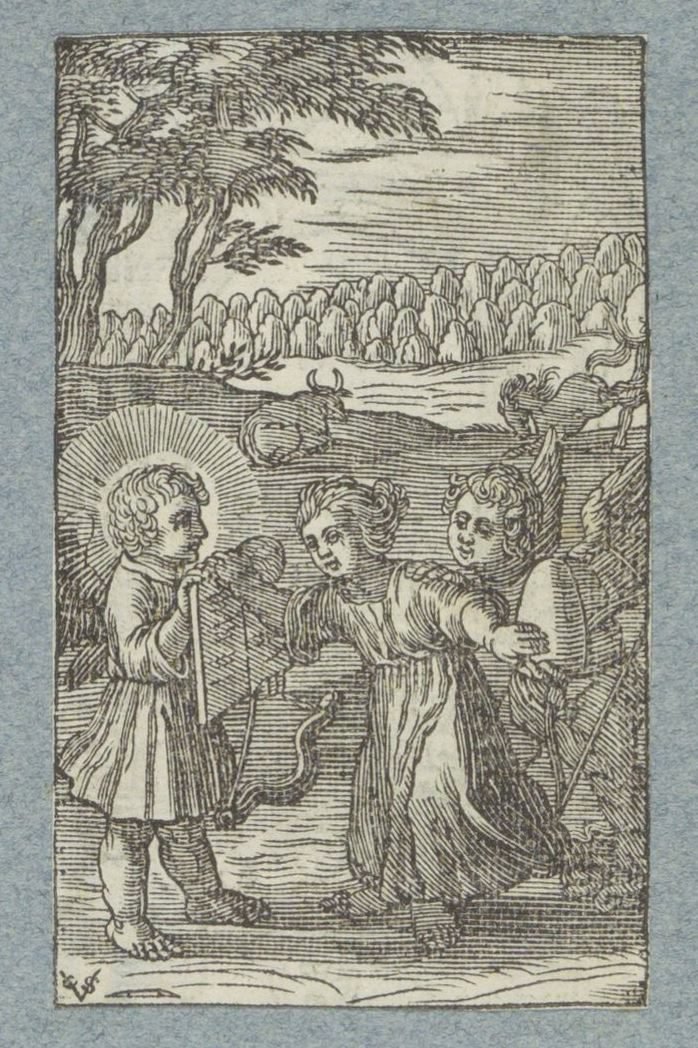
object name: album leaf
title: Pia Desideria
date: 1628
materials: paper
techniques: woodcut, pasting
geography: amsterdam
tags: the ten commandments represented together on stone tablets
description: Prent uit: Herman Hugo, Pia desideria emblematis, elegiis & affectibus S. S. Patrum illustrata, Antwerpen 1628. Volgens de titelpagina verscheen dit werk in Antwerpen bij Hendrick Aertssens, in werkelijkheid verscheen het in Amsterdam bij Pieter Jacobsz Paets (Dietz 2012, p. 58-59).